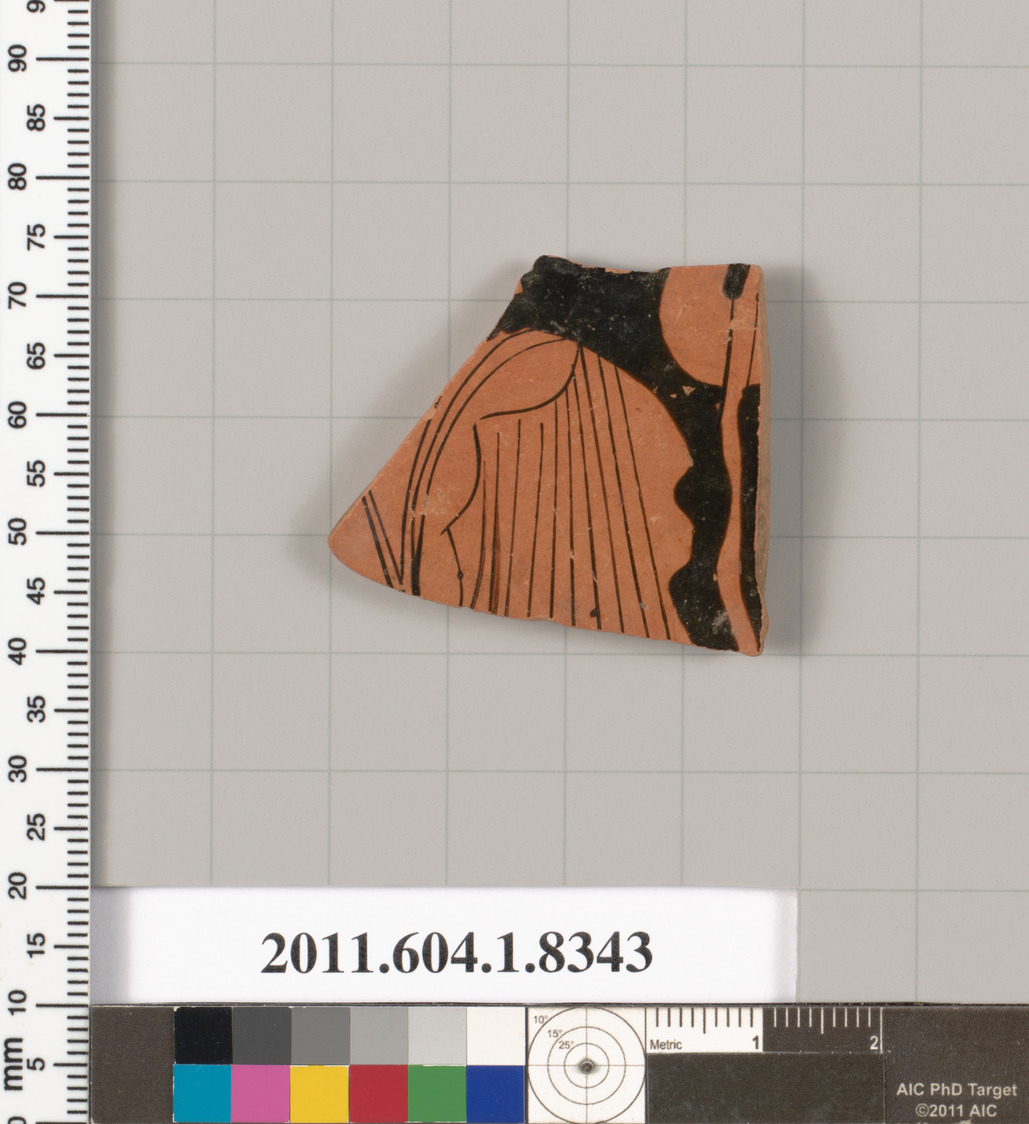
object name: kylix fragment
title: Terracotta fragment of a kylix (drinking cup)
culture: greek, attic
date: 467-435 BCE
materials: terracotta